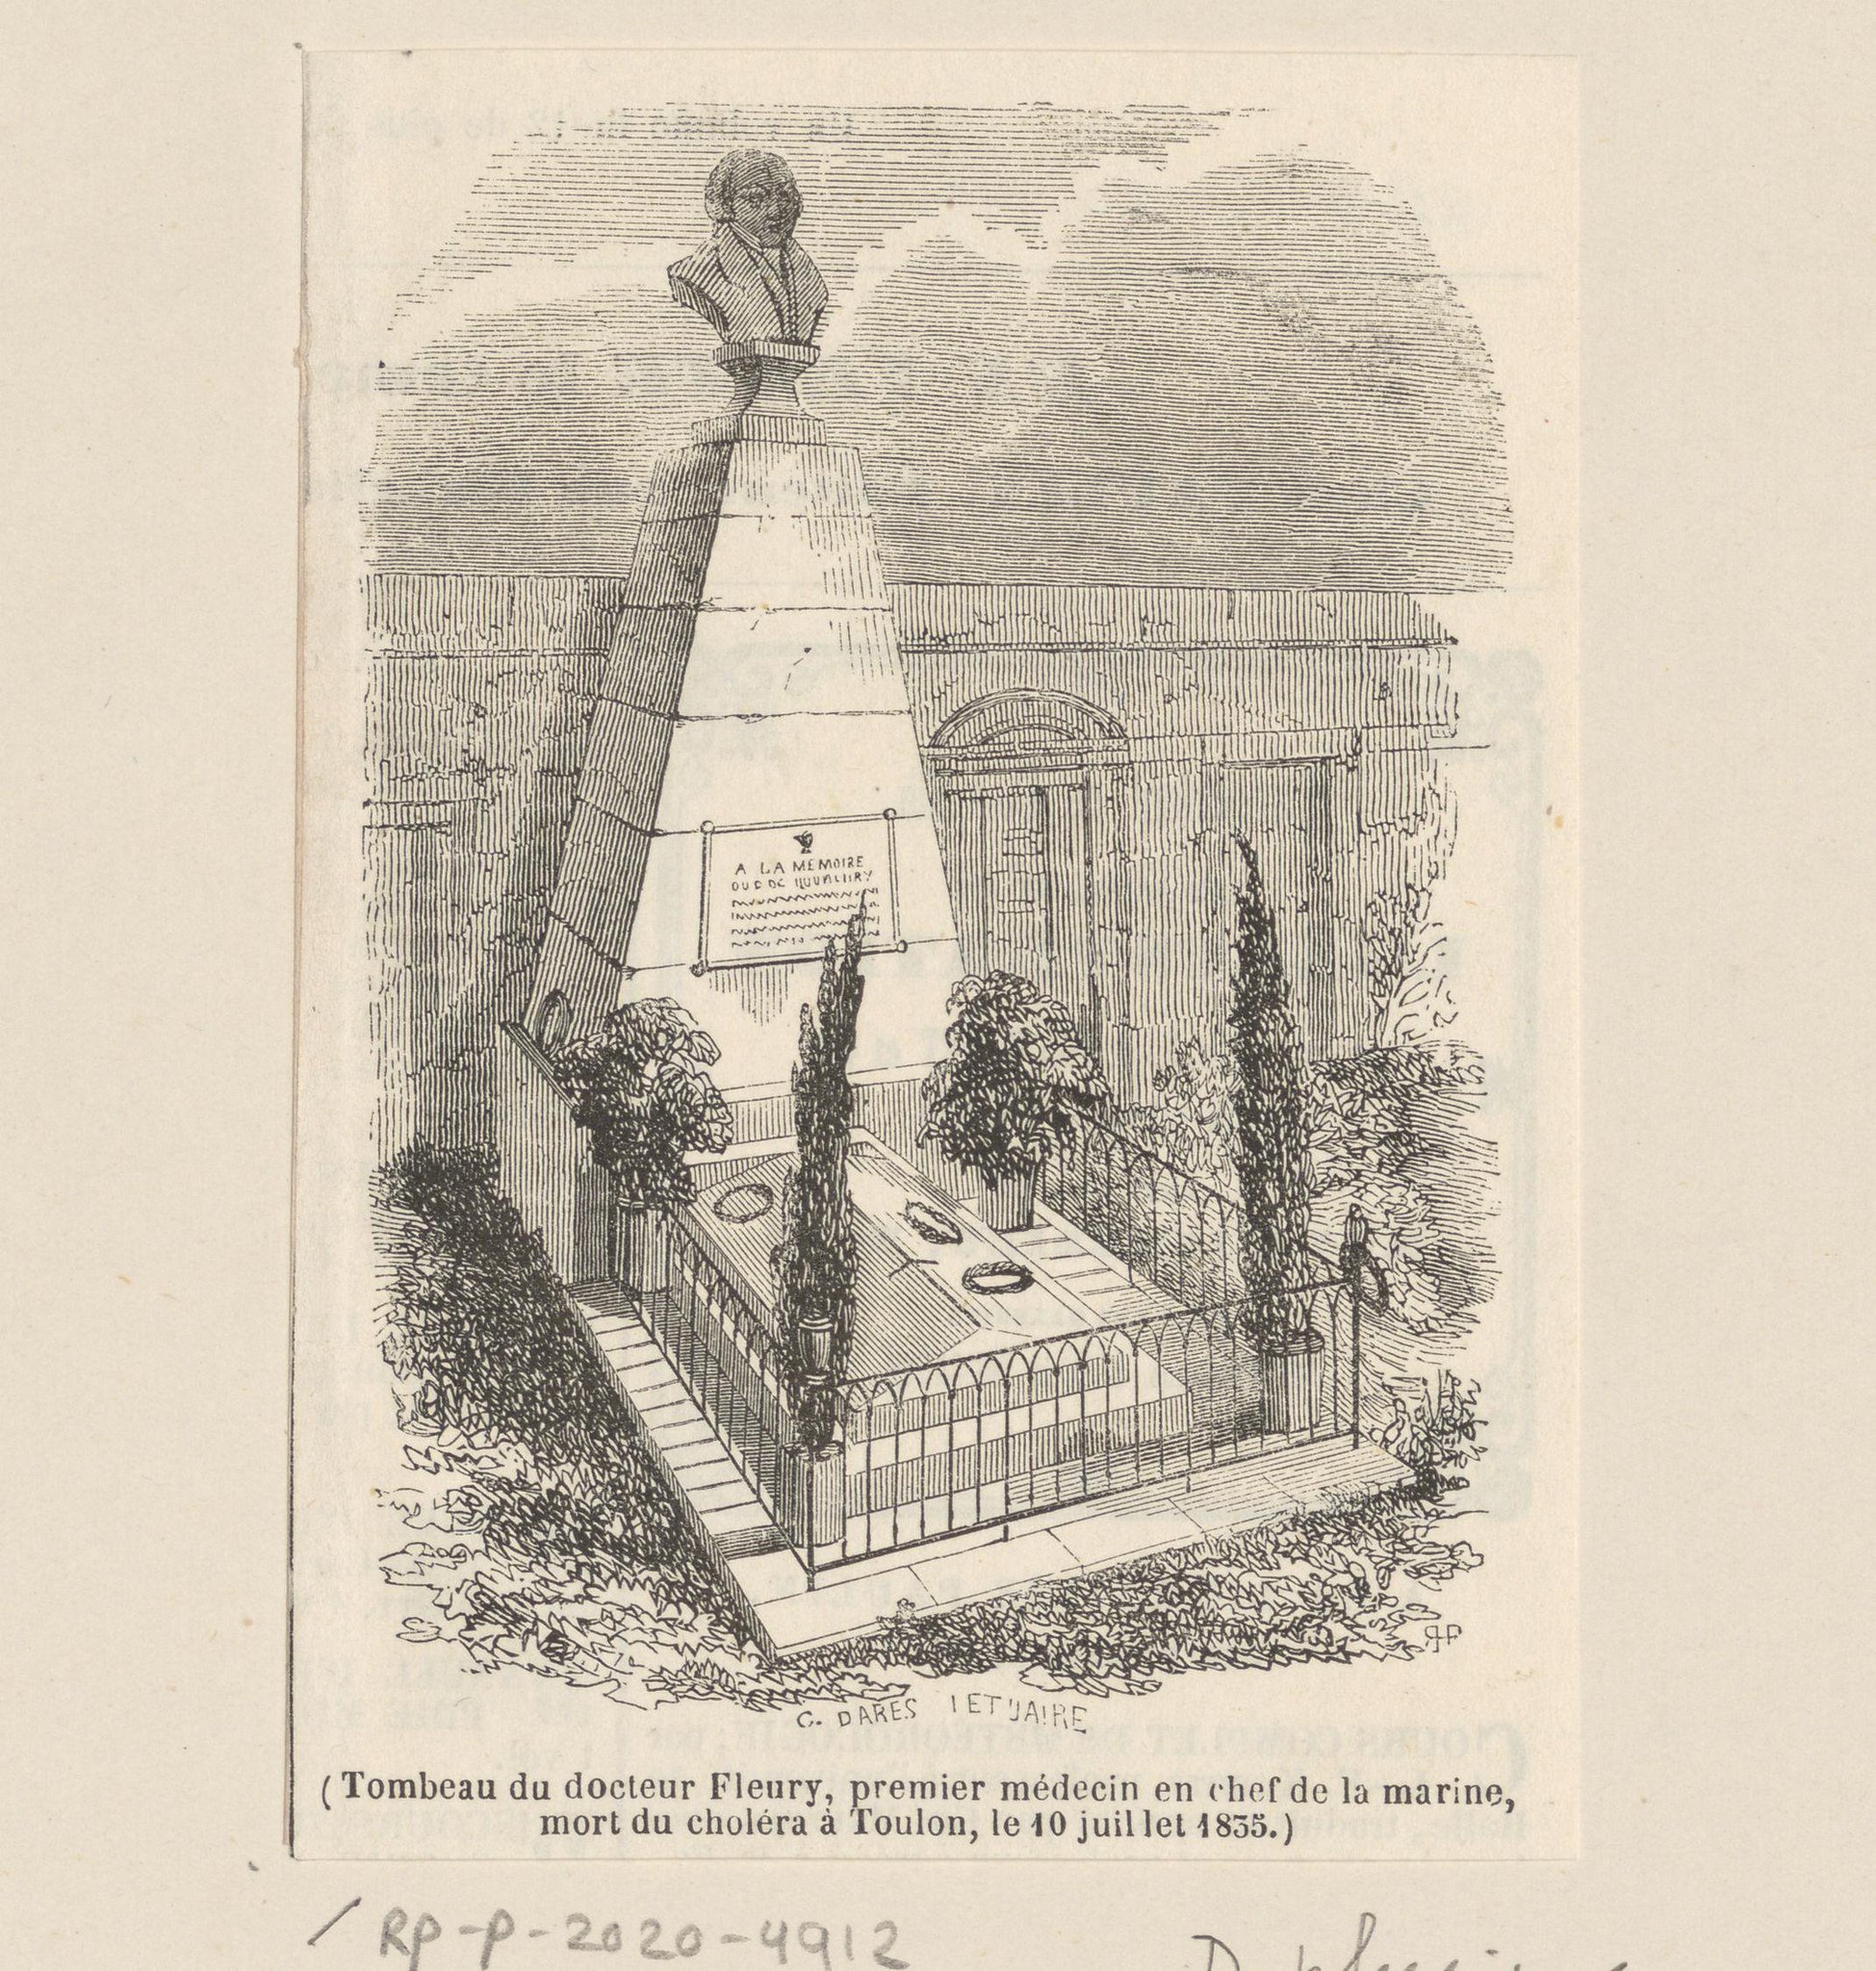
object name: print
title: Graftombe van Jean André Fleury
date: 1844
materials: paper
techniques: letterpress printing, engraving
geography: france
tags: historical persons, grave, tomb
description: Prent uit: L'Illustration 3 (1844), nr. 78, 24 augustus 1844.